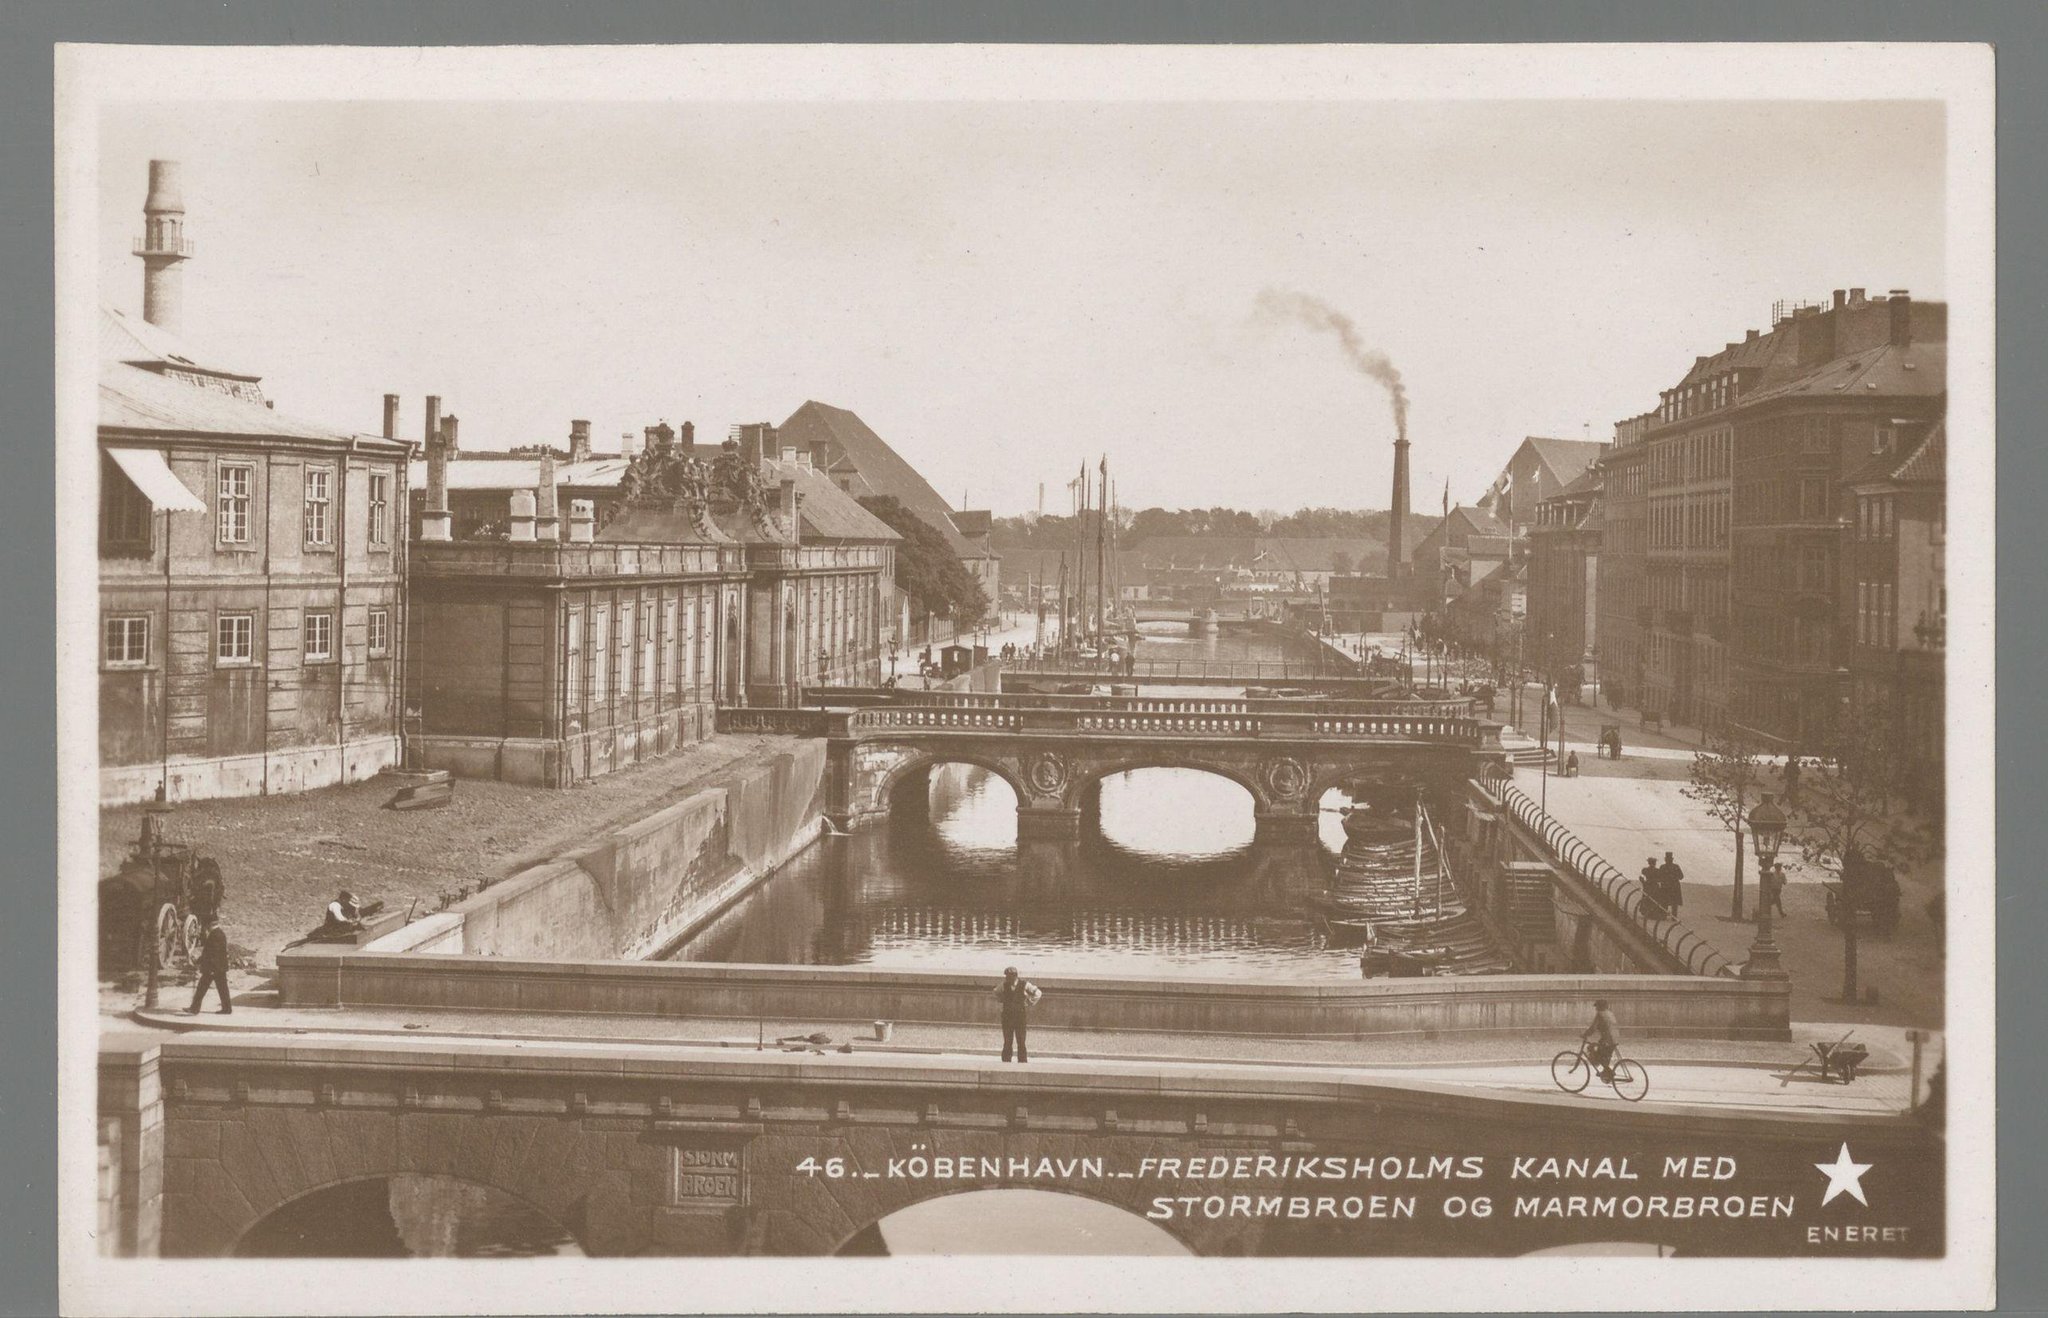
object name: photograph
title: Köbenhavn. Frederiksholms Kanal Med Strombroen og Marmorbroen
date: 1906-1920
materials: photographic support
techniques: photography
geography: copenhagen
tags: bridge in city across river, canal, etc. (+ city(-scape) with figures, staffage), canal, copenhagen (city)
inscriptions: mark